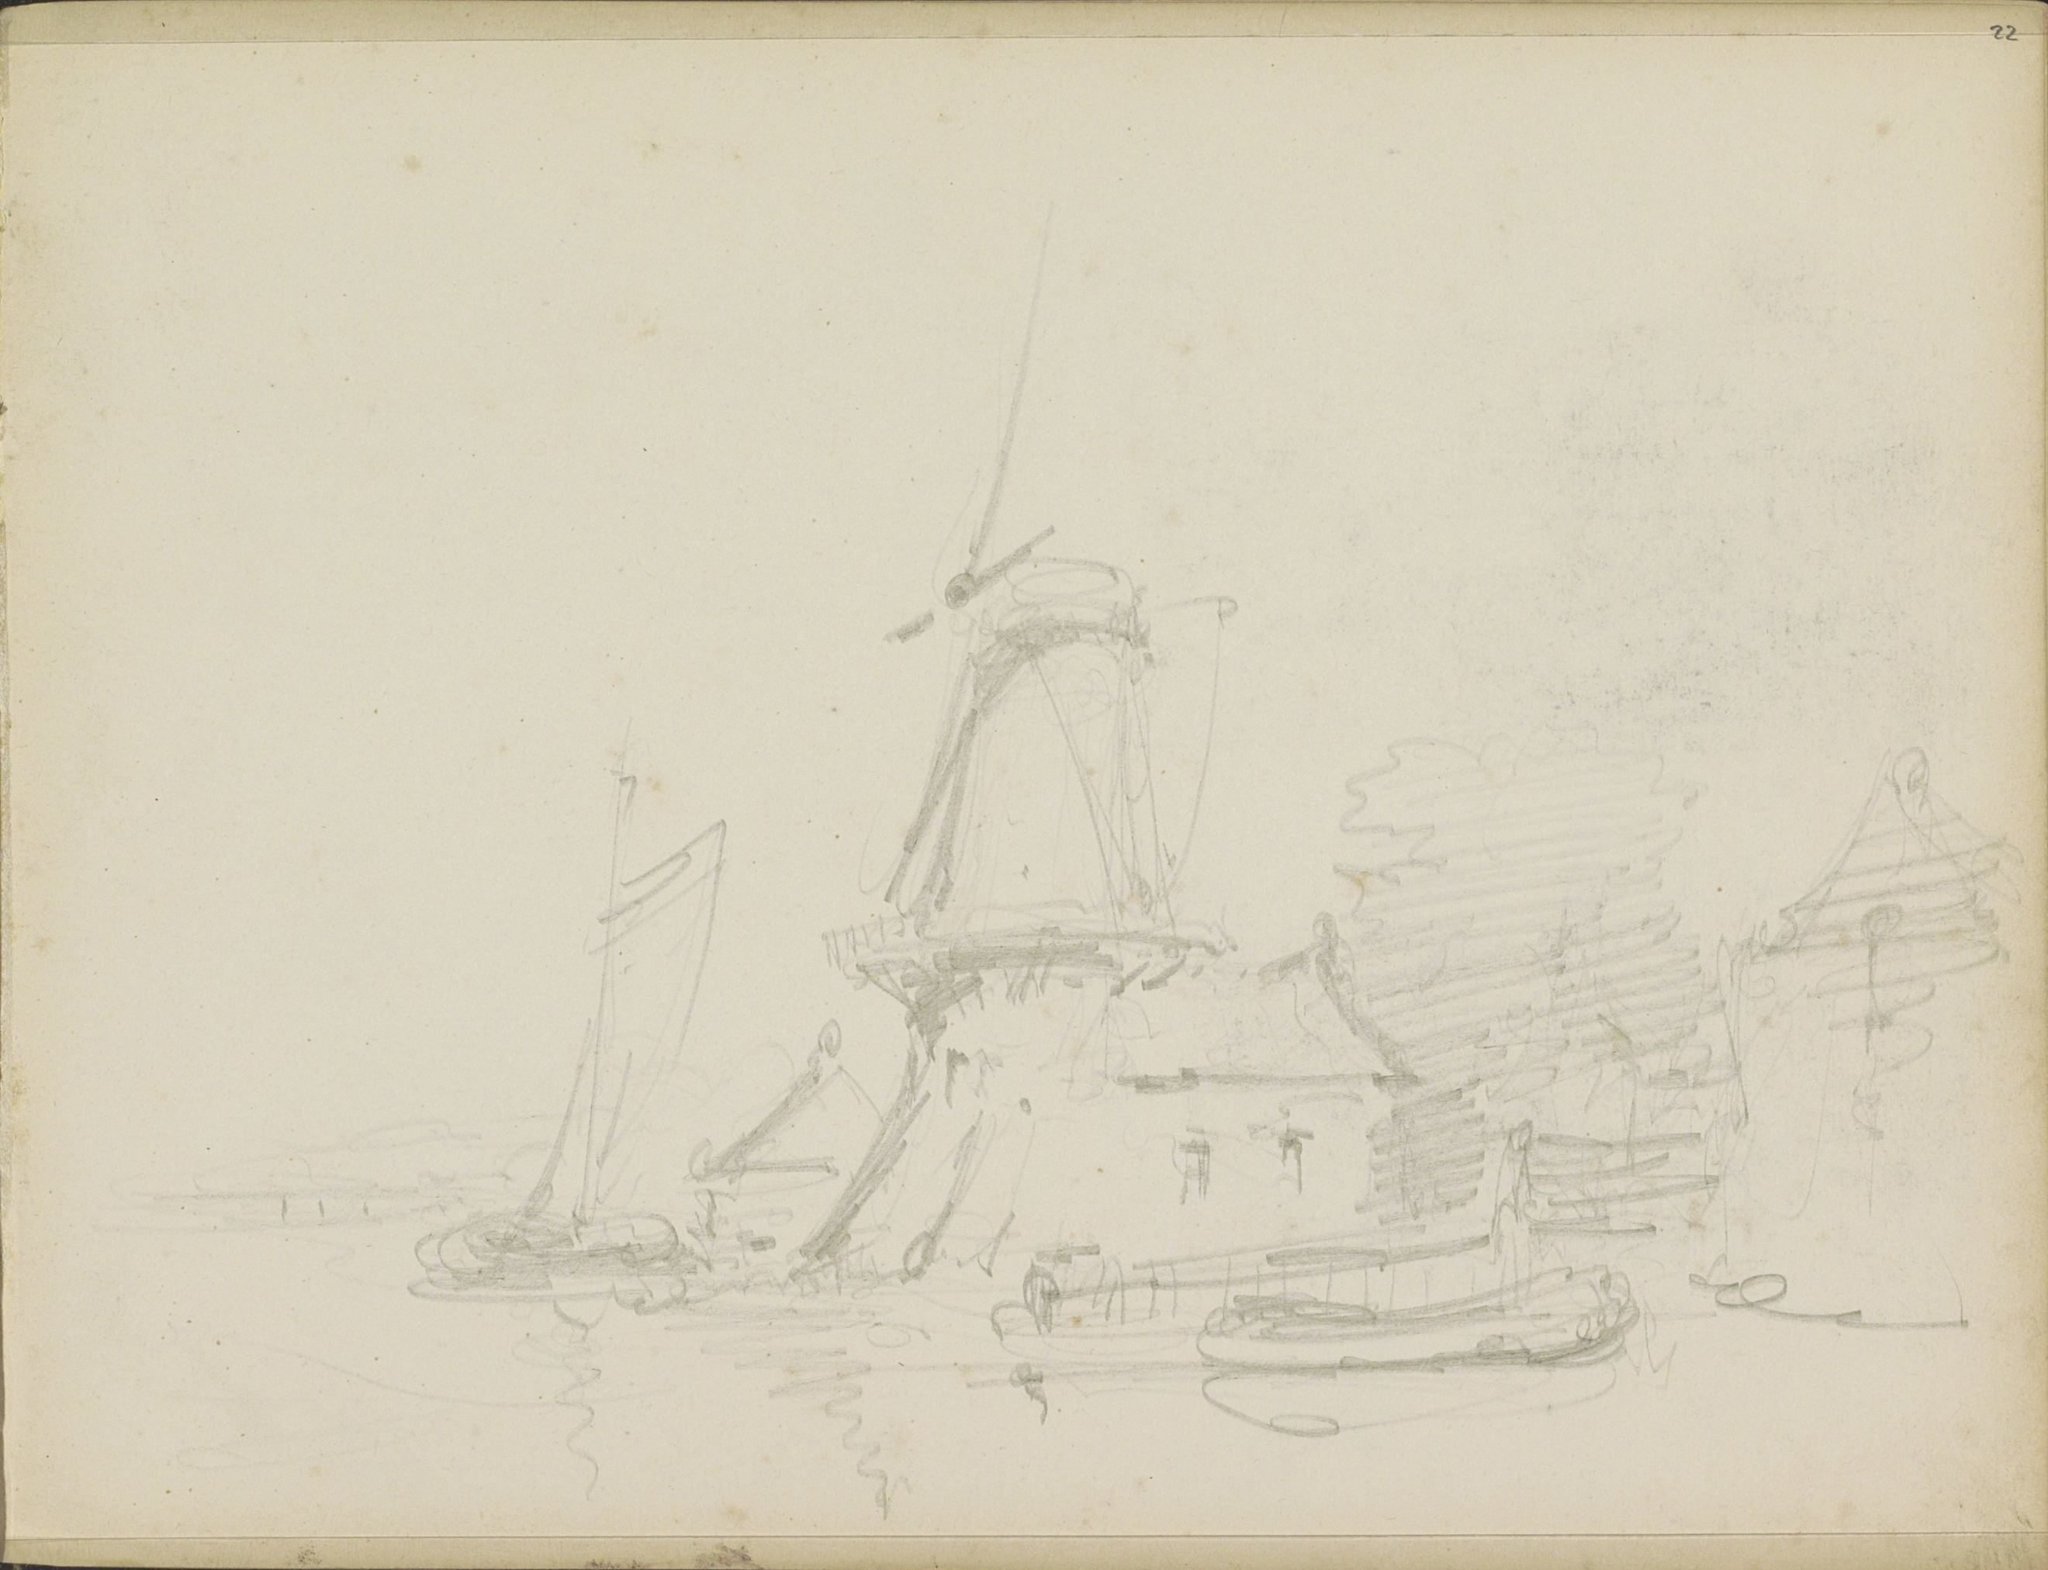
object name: sketchbook leaf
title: Rivierlandschap met een molen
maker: adrianus eversen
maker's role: draughtsman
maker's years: 1818-1897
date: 1828-1897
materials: paper, pencil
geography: netherlands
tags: sailing-ship, sailing-boat, river, rowing-boat, canoe, etc., windmill in landscape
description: Aan het water staat een molen. Links een zeilschip en rechts een roeiboot. Blad 22 recto uit een schetsboek met 41 bladen.